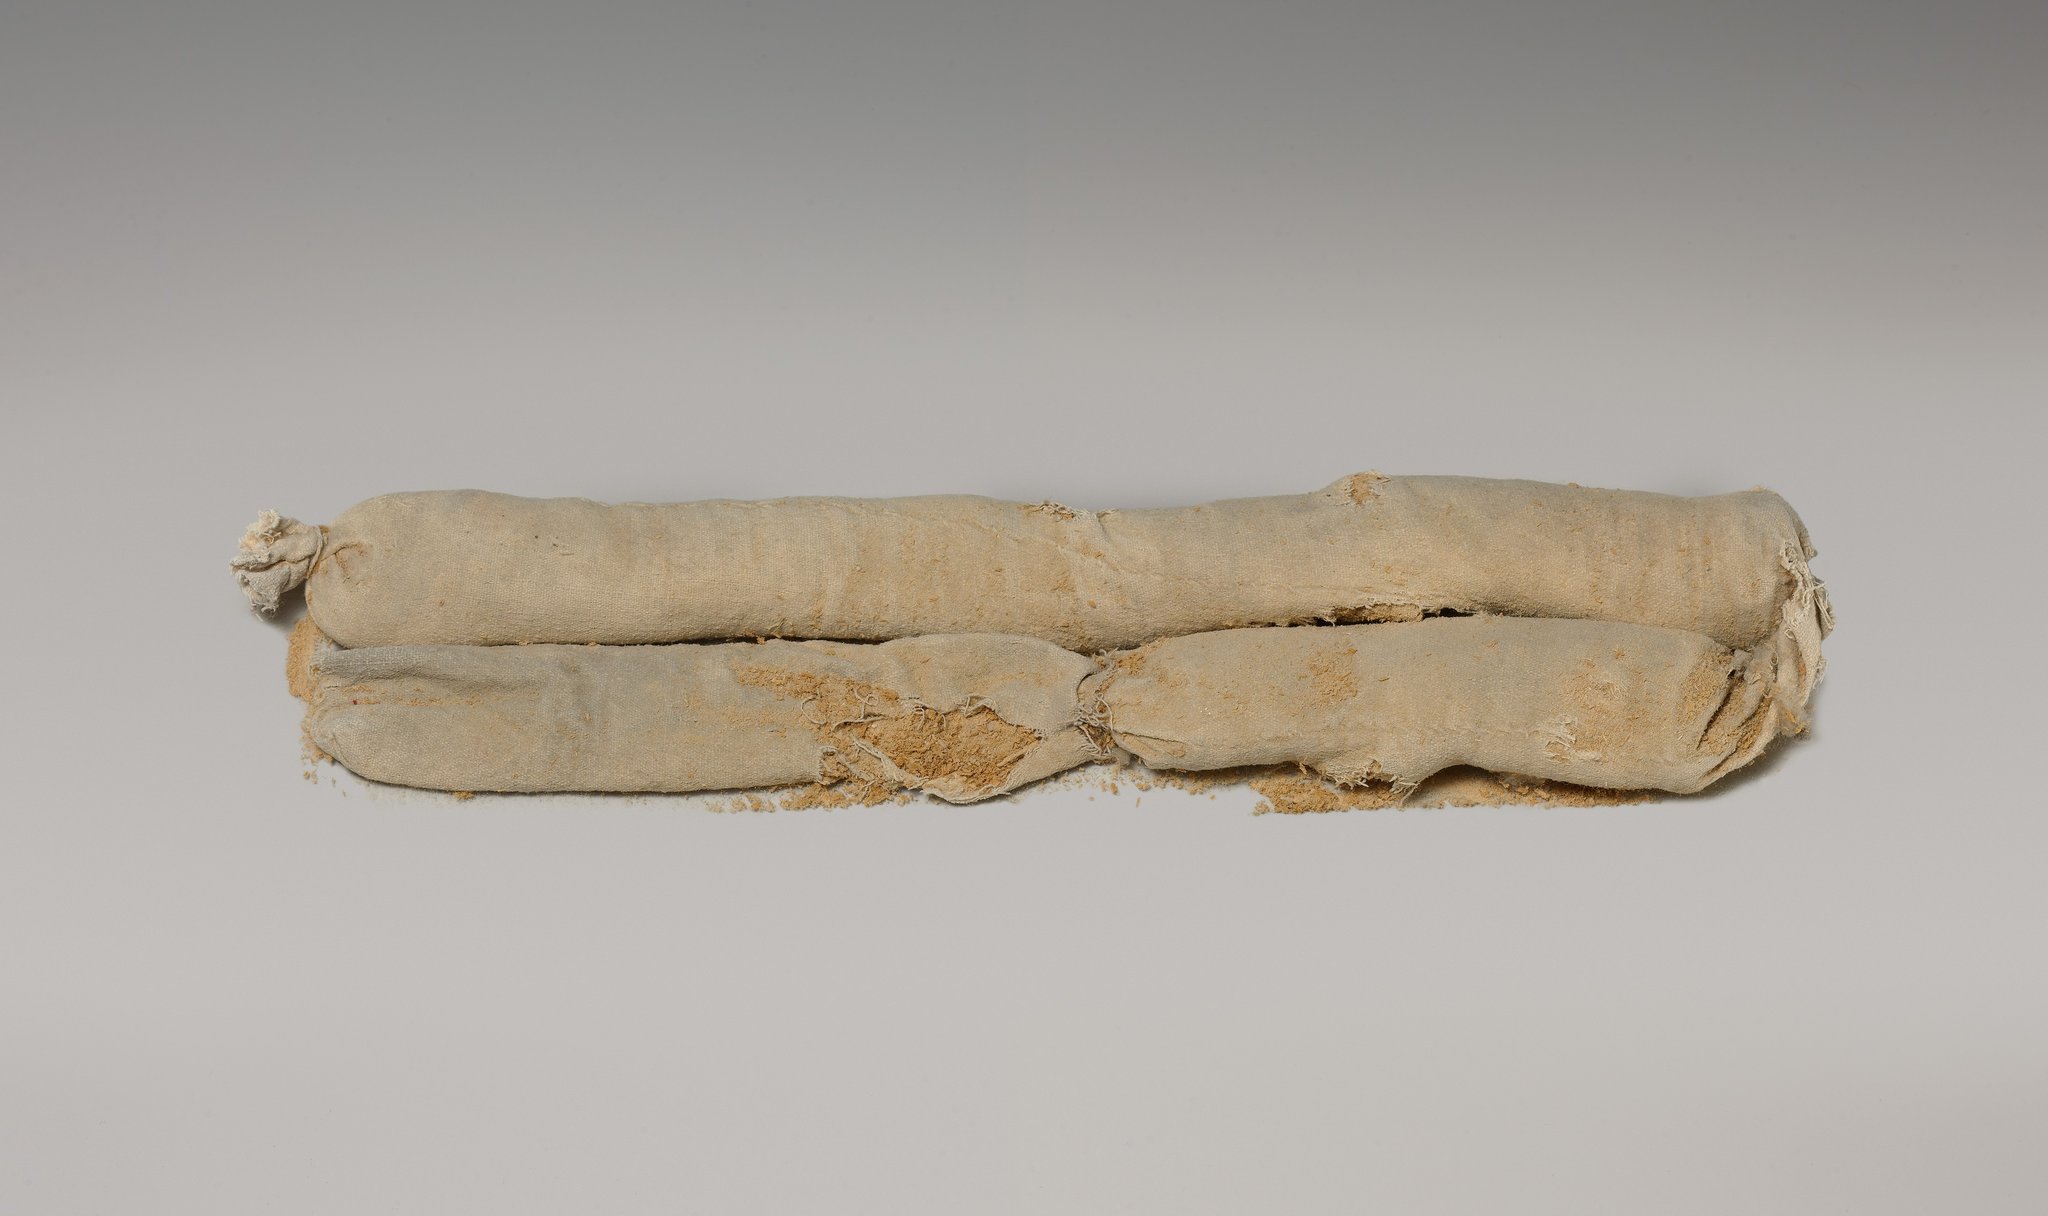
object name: cylindrical bag of sawdust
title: Cylindrical bag of sawdust from Tutankhamun's Embalming Cache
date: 1336-1327 BCE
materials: linen, wood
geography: egypt